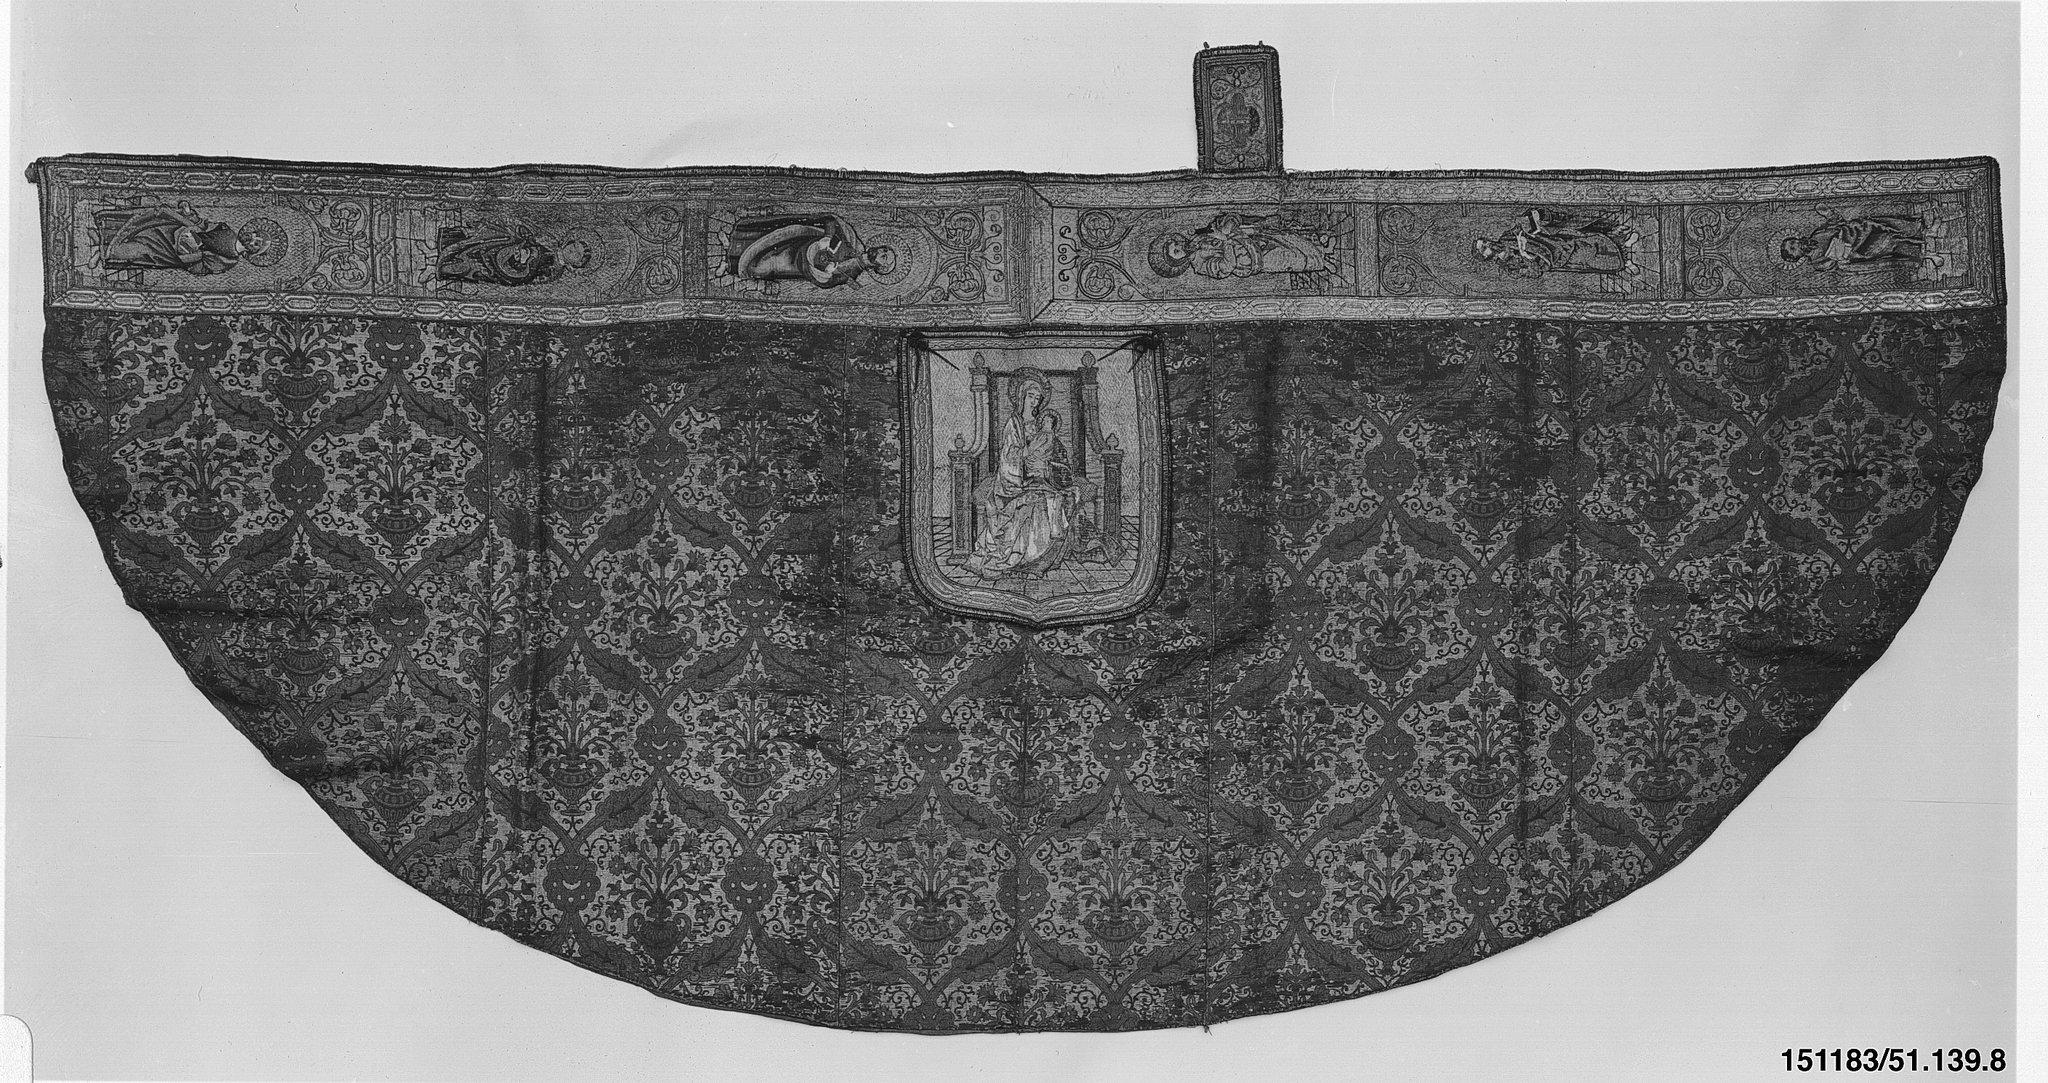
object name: cope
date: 1501-1600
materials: linen, metal thread, silk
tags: madonna and child